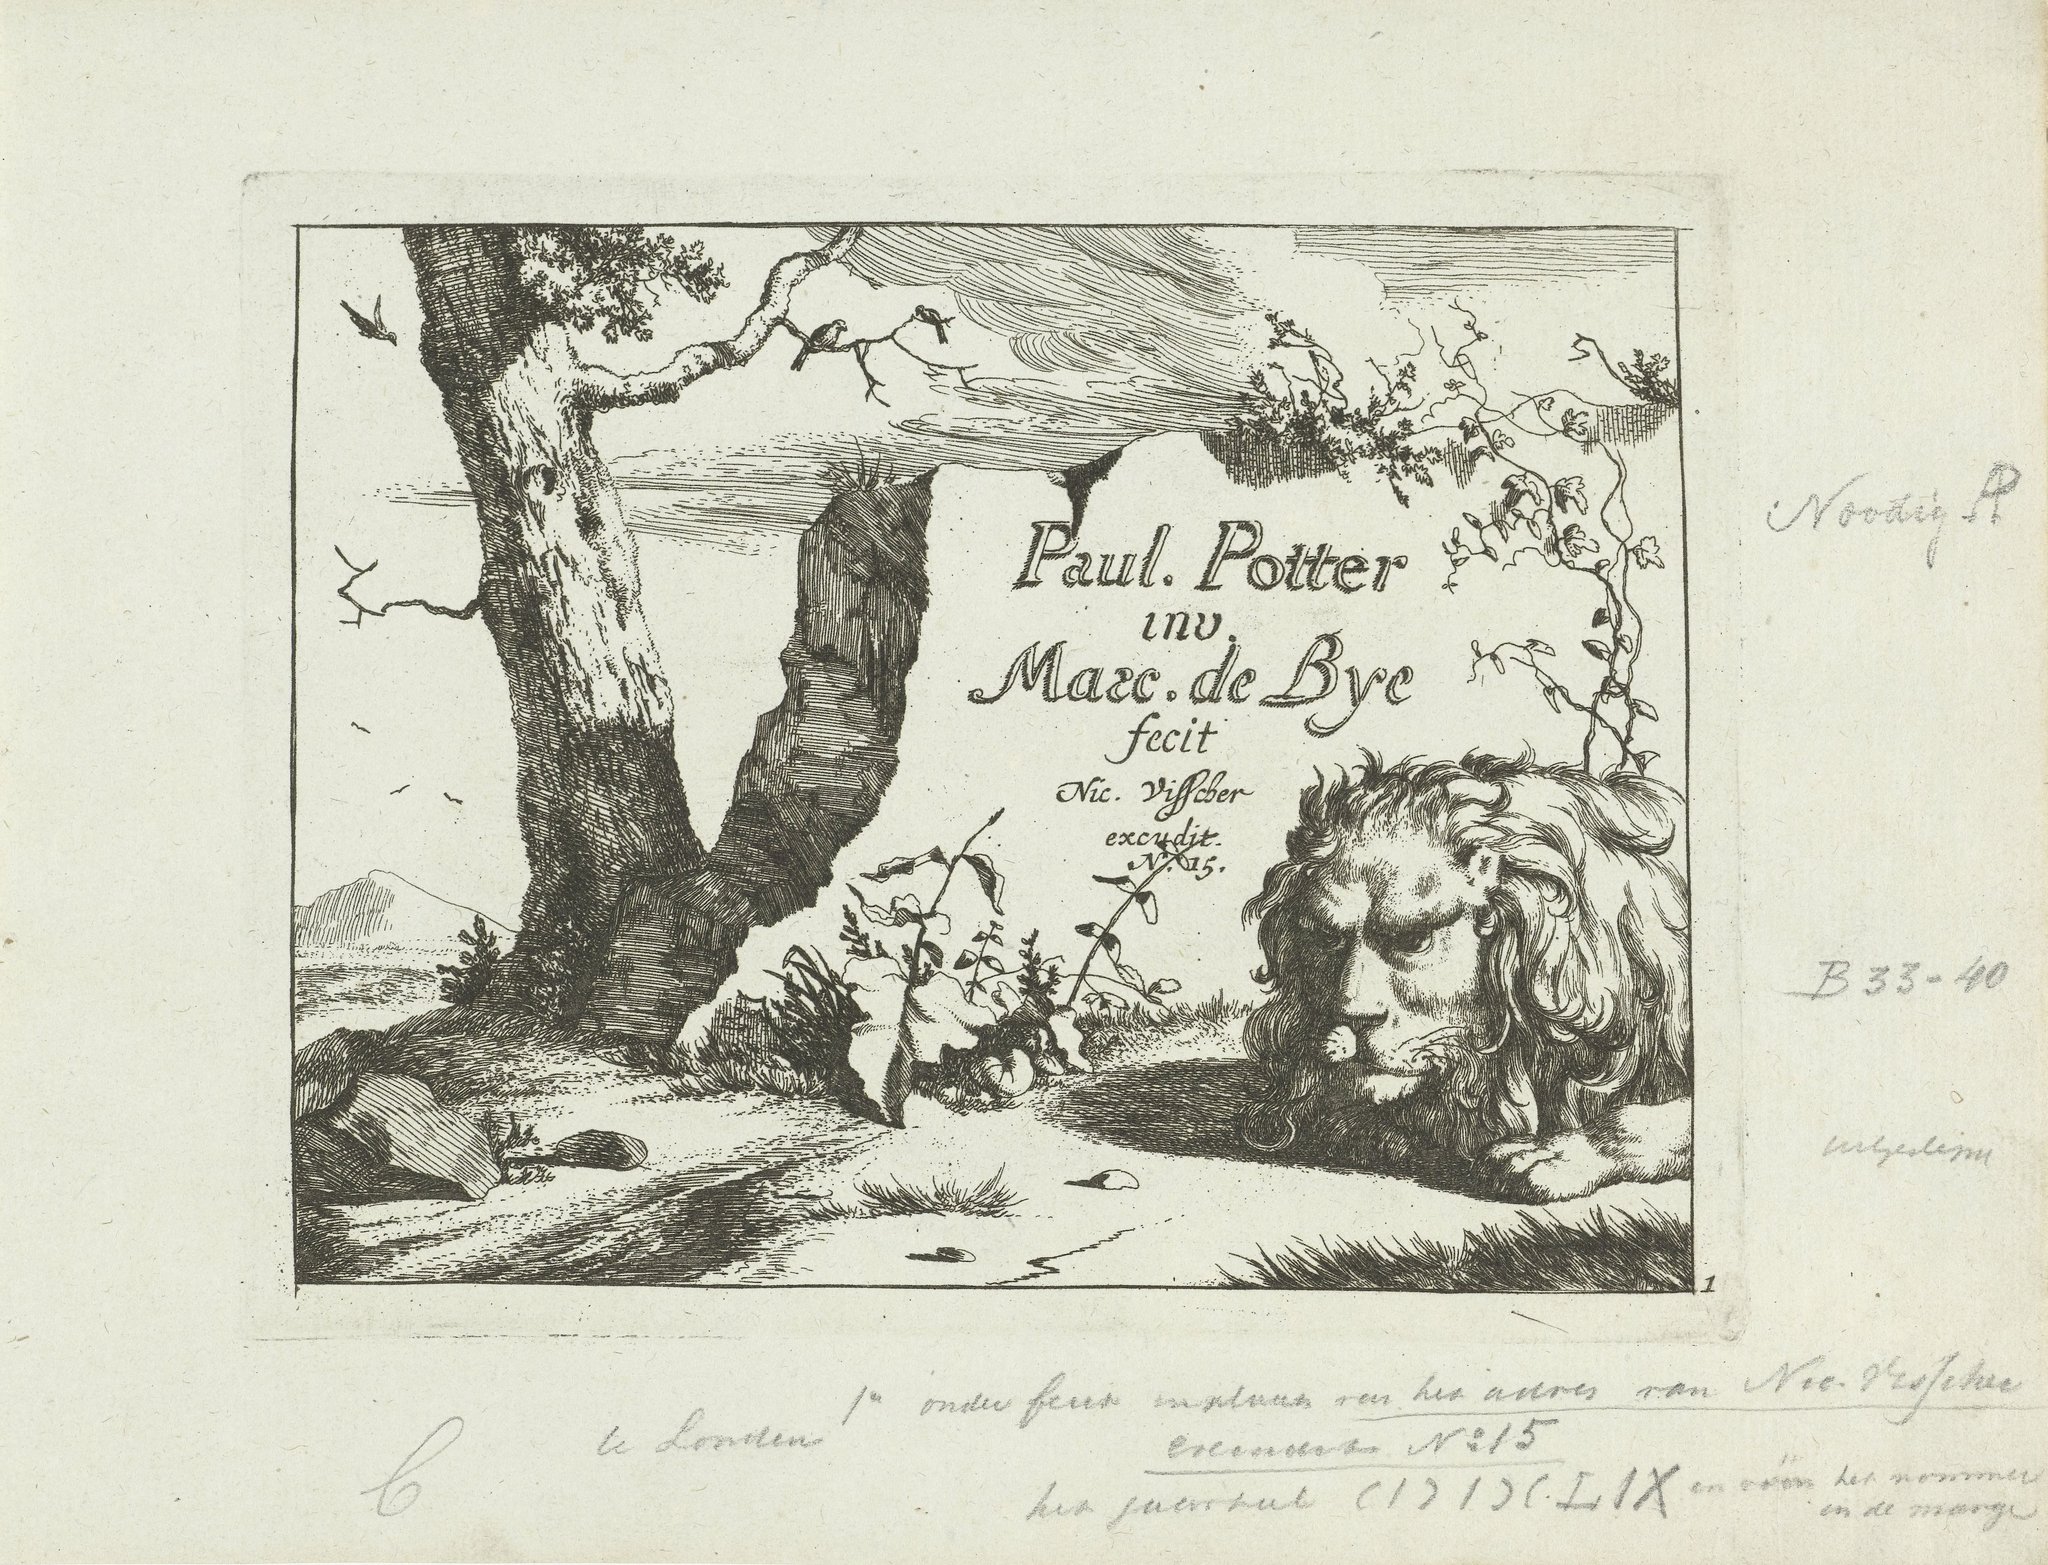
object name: print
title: Leeuw liggend bij boom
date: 1659-1677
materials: paper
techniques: etching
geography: the hague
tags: beasts of prey, predatory animals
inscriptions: collector's mark: Lugt 2228